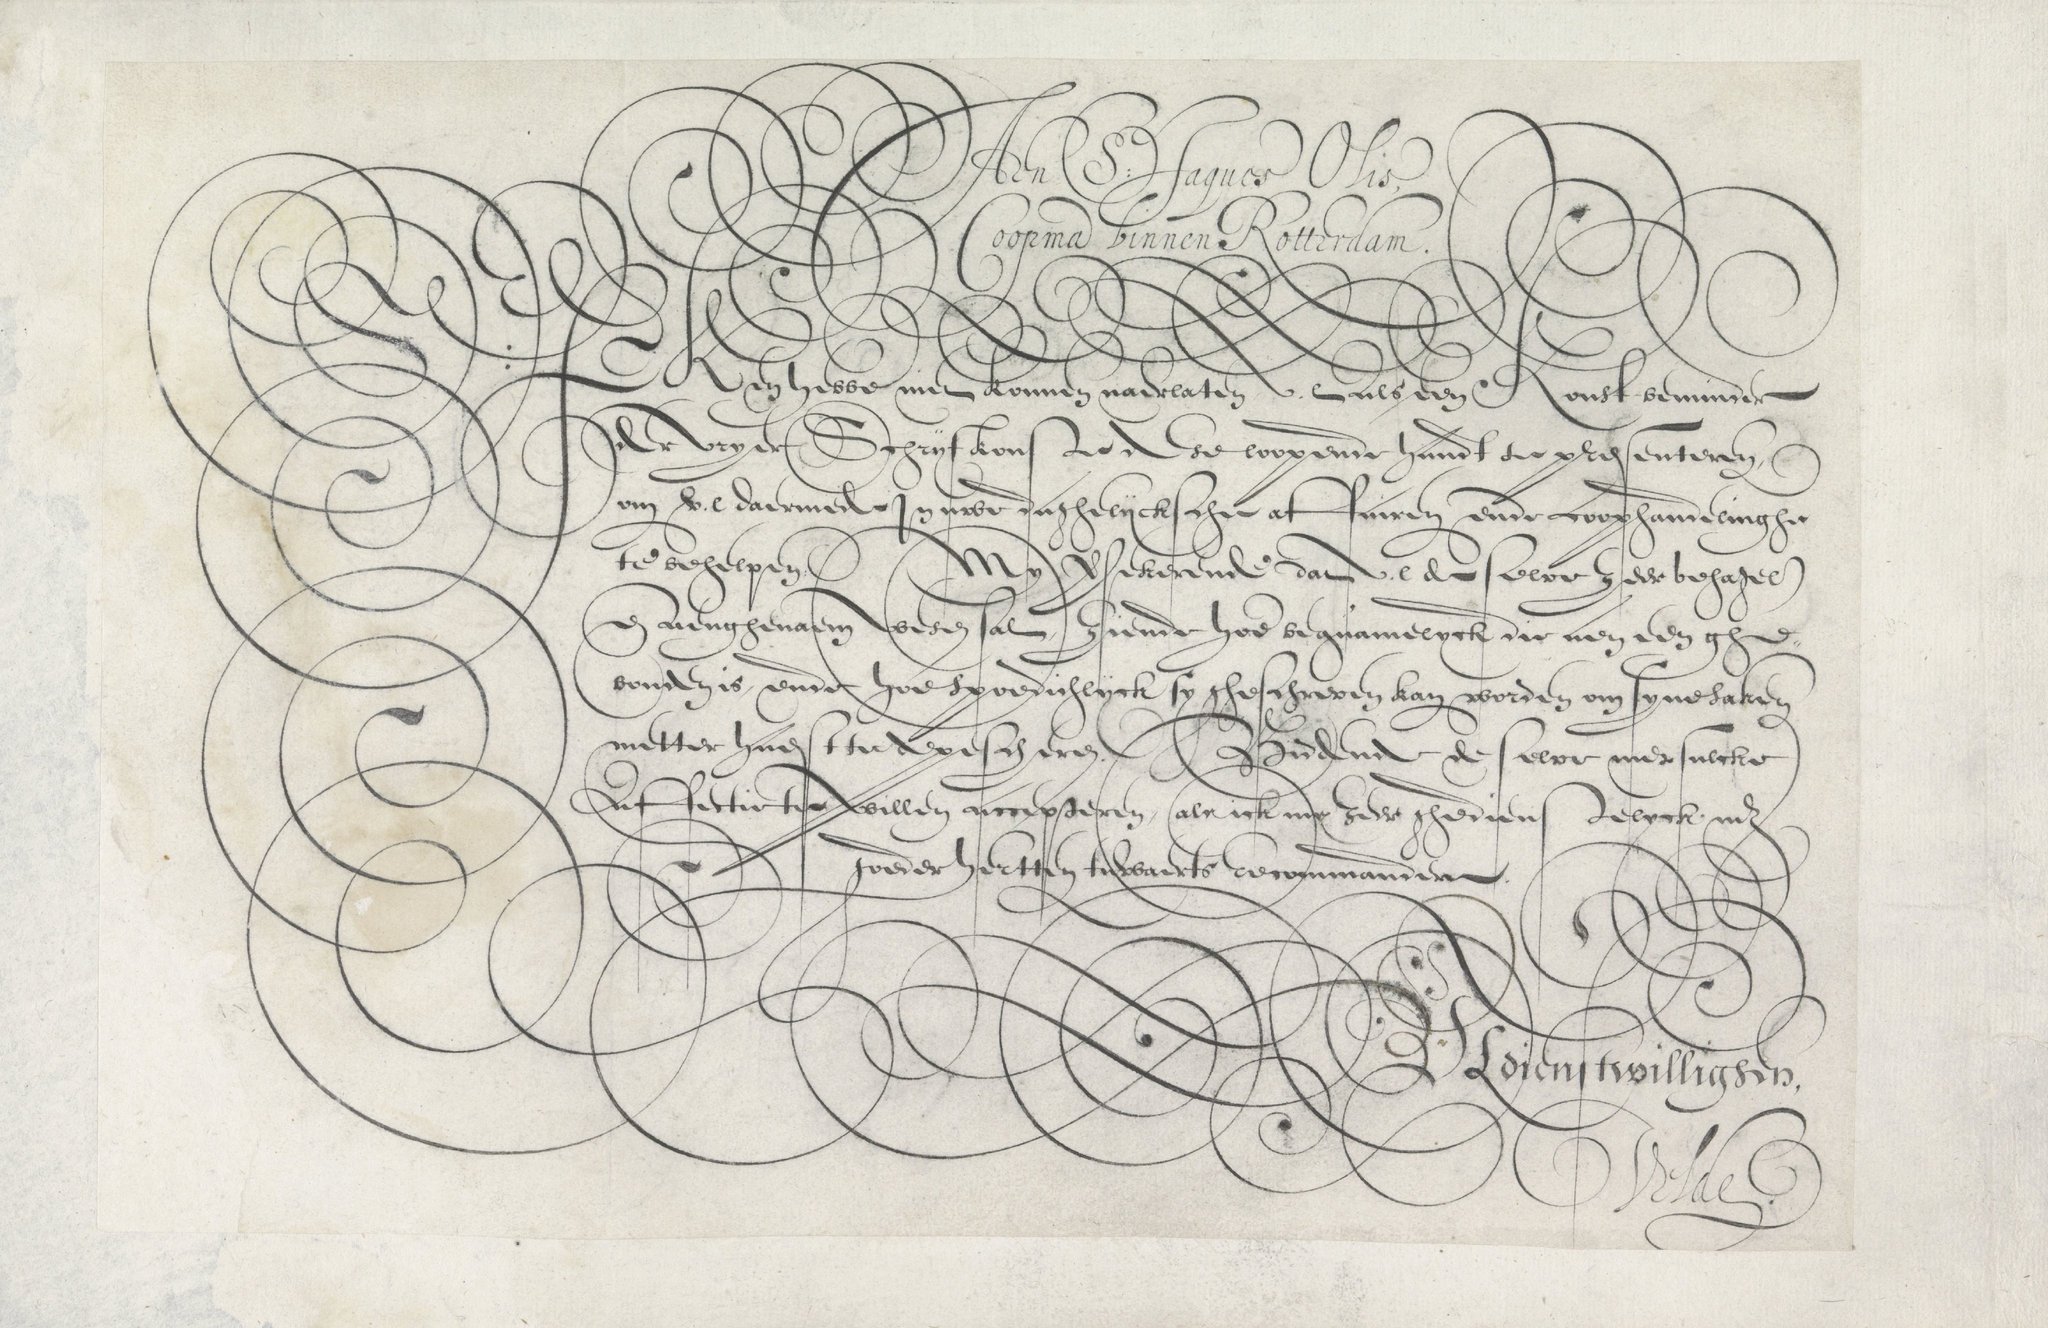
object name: album leaf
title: Spieghel der schrijfkonste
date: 1605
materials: ink, paper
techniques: calligraphy, pen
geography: rotterdam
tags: calligraphy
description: Kalligrafische tekening met de aanhef: Aen S. Jacques Olis, coopman binnen Rotterdam. Daaronder in een andere letter een geornamenteerde initiaal I en negen regels tekst in het Nederlands: Ick en hebbe niet konnen naerlaten ... De tekst is omlijst door krulwerk. De tekening maakt deel uit van een album.